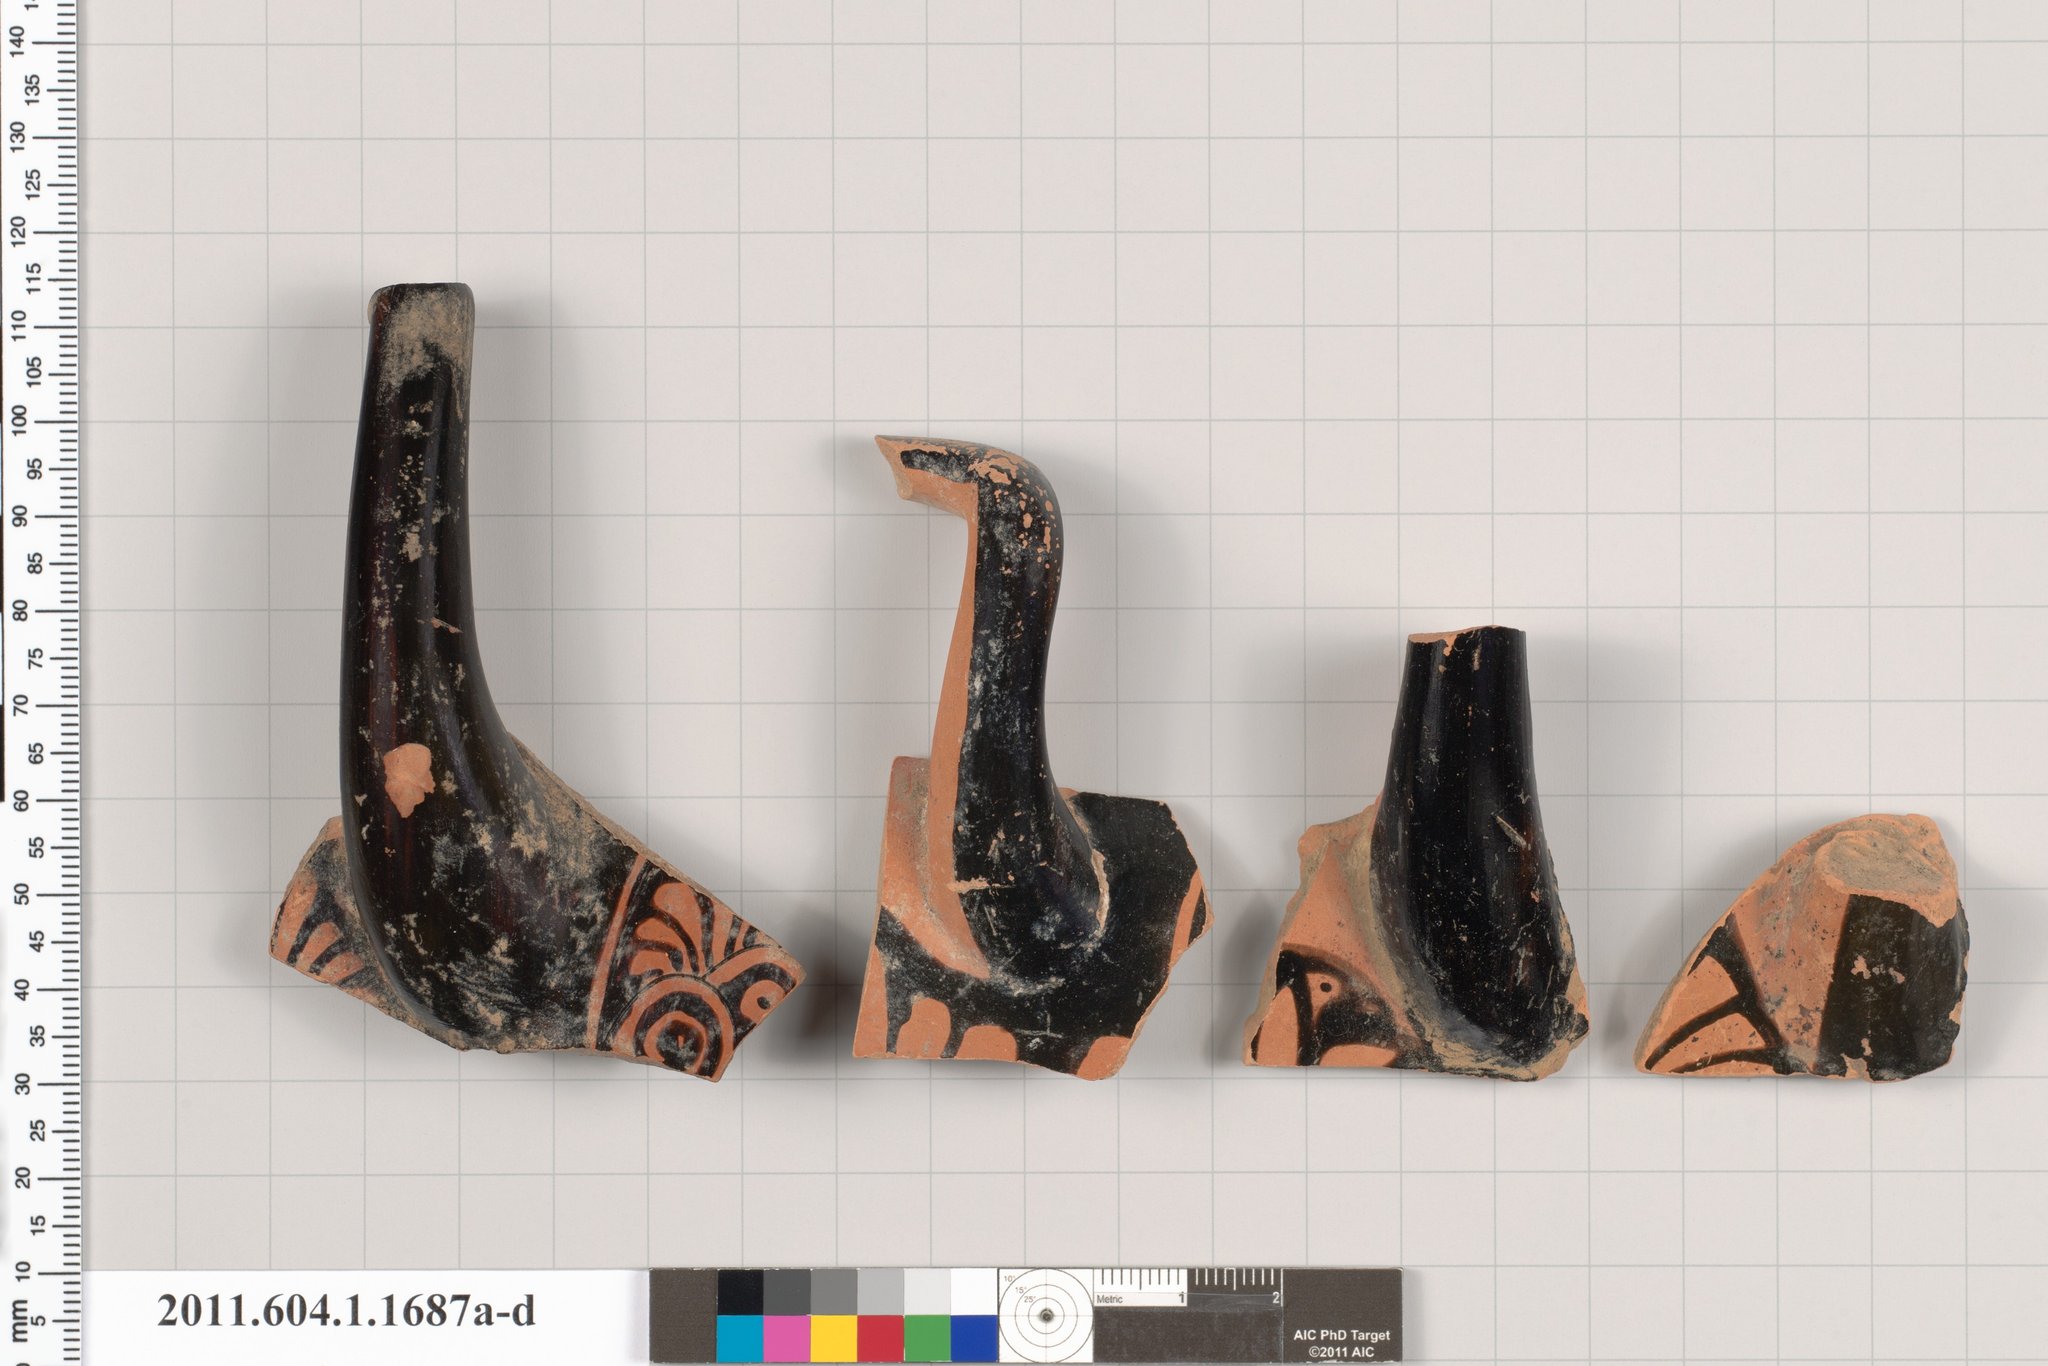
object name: kylix fragment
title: Terracotta fragments of kylikes (drinking cups)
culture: greek, attic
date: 500-401 BCE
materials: terracotta